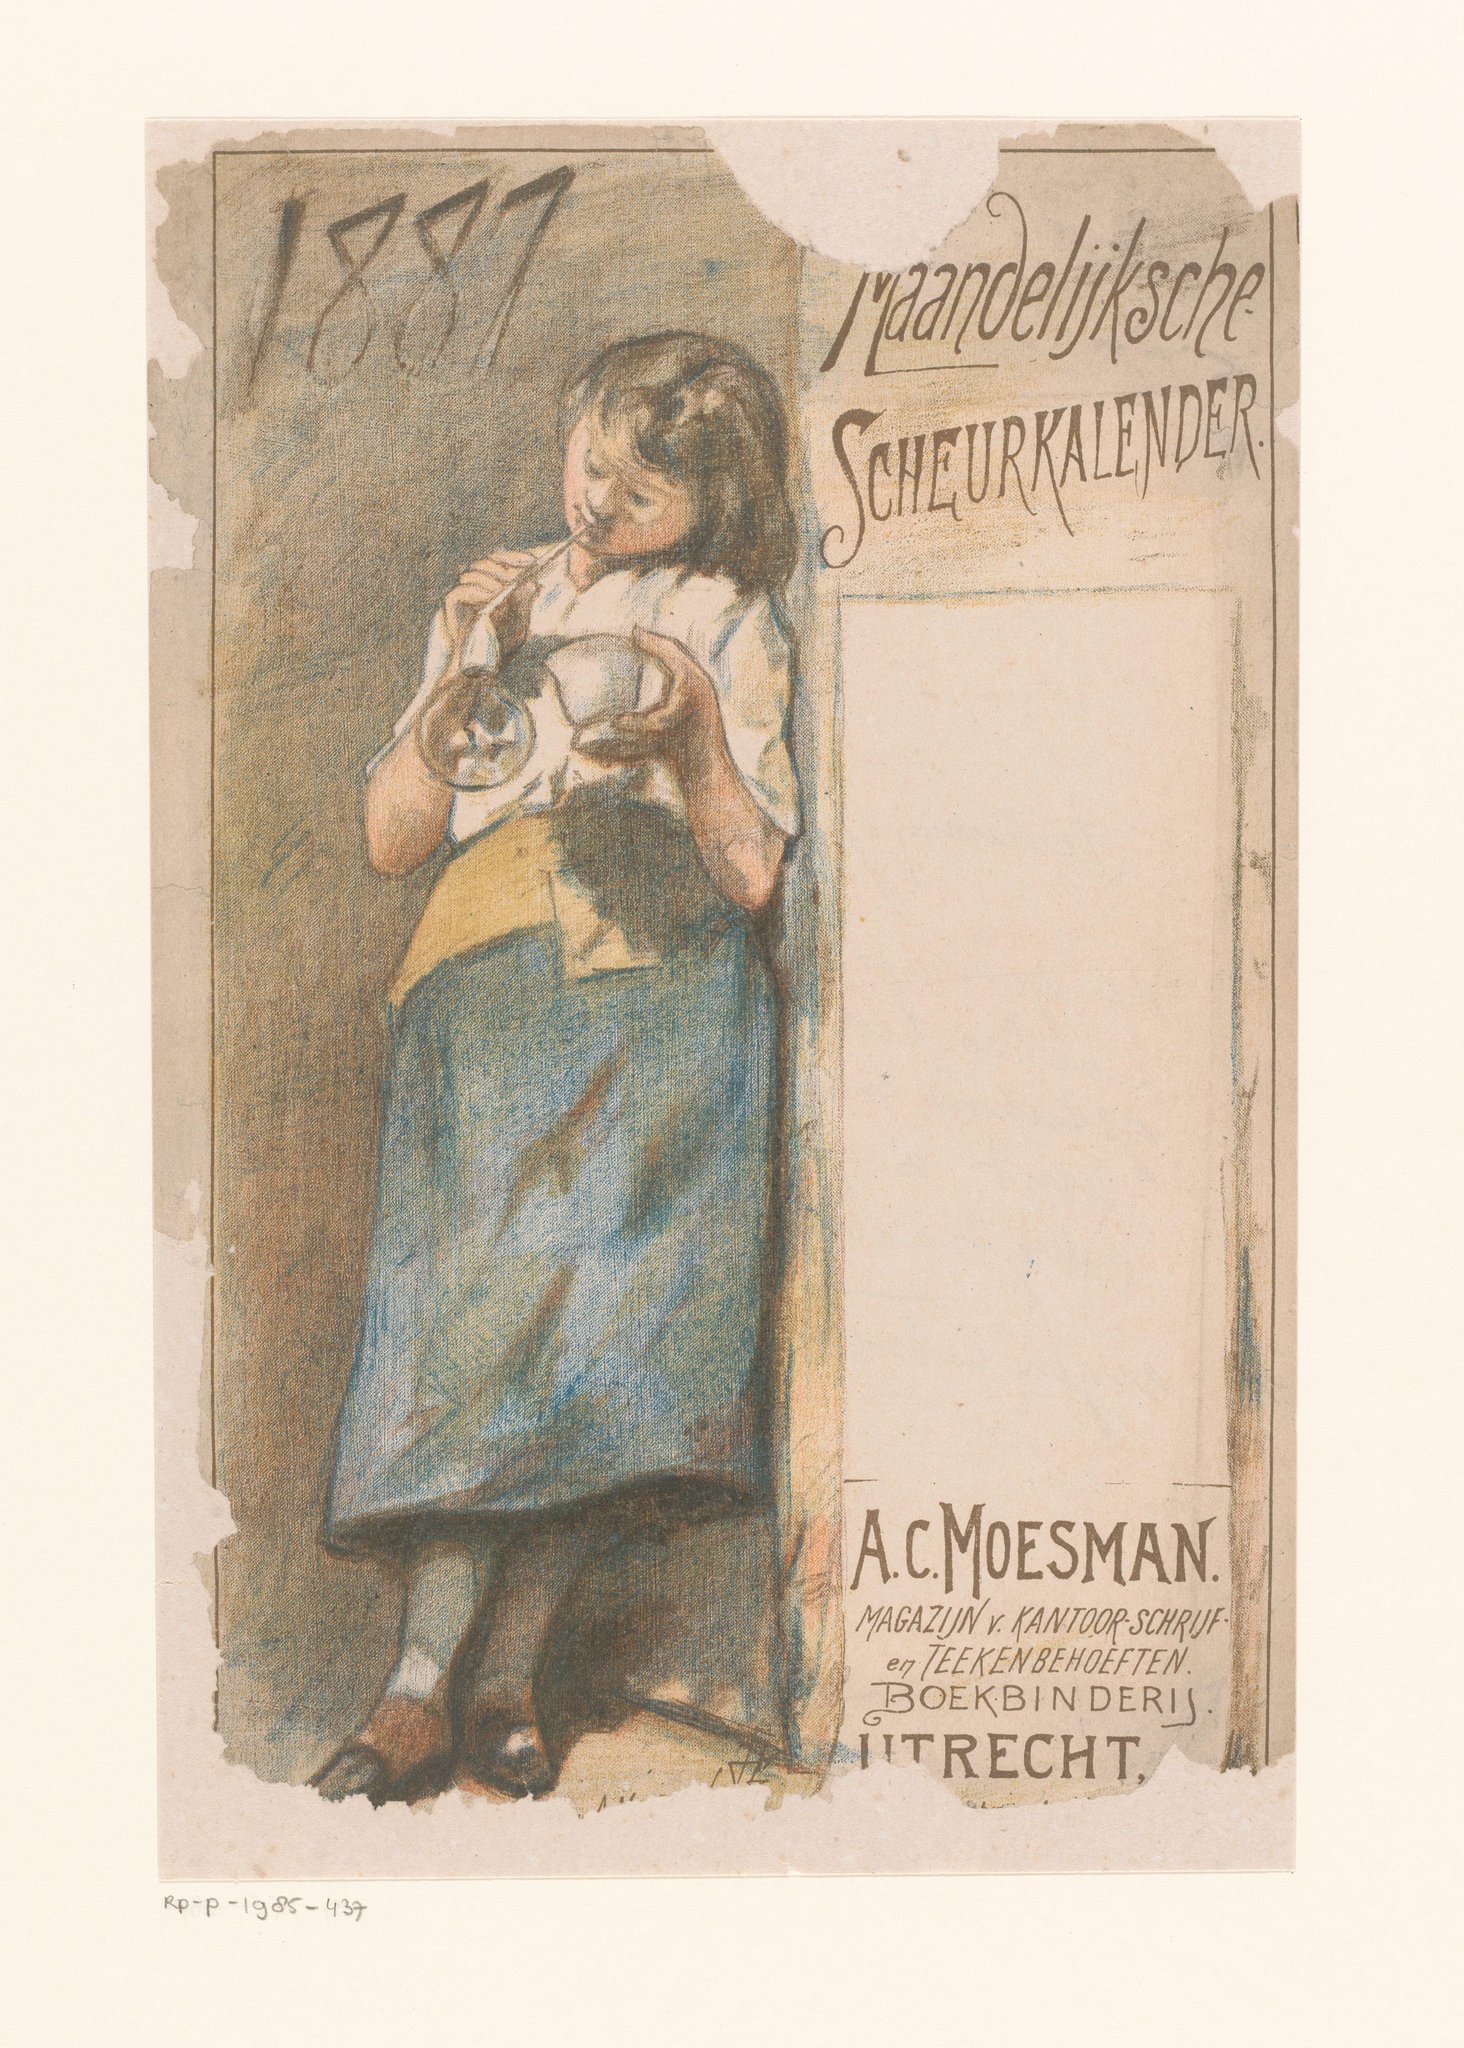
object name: print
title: Maandelijksche Scheurkalender 1887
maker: johannes moesman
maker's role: draughtsman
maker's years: 1859-1937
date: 1887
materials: paper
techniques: lithograph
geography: utrecht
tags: bubble-blowing (children's games and plays), adolescent, young woman, maiden, calendar, almanac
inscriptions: inscription: ‘Teekening Joh. A. Moesman / op geprepareerd / Calkeerlinnen / geteekend met lithog. / krijt en op steen / overgebracht en gebrukt / eigen uitvinding’, collector's mark: Lugt 2760, collector's mark: Lugt 2228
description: Bij deze prent is gebruikt maakt van calqueerlinnen om de tekening over te brengen op de steen.